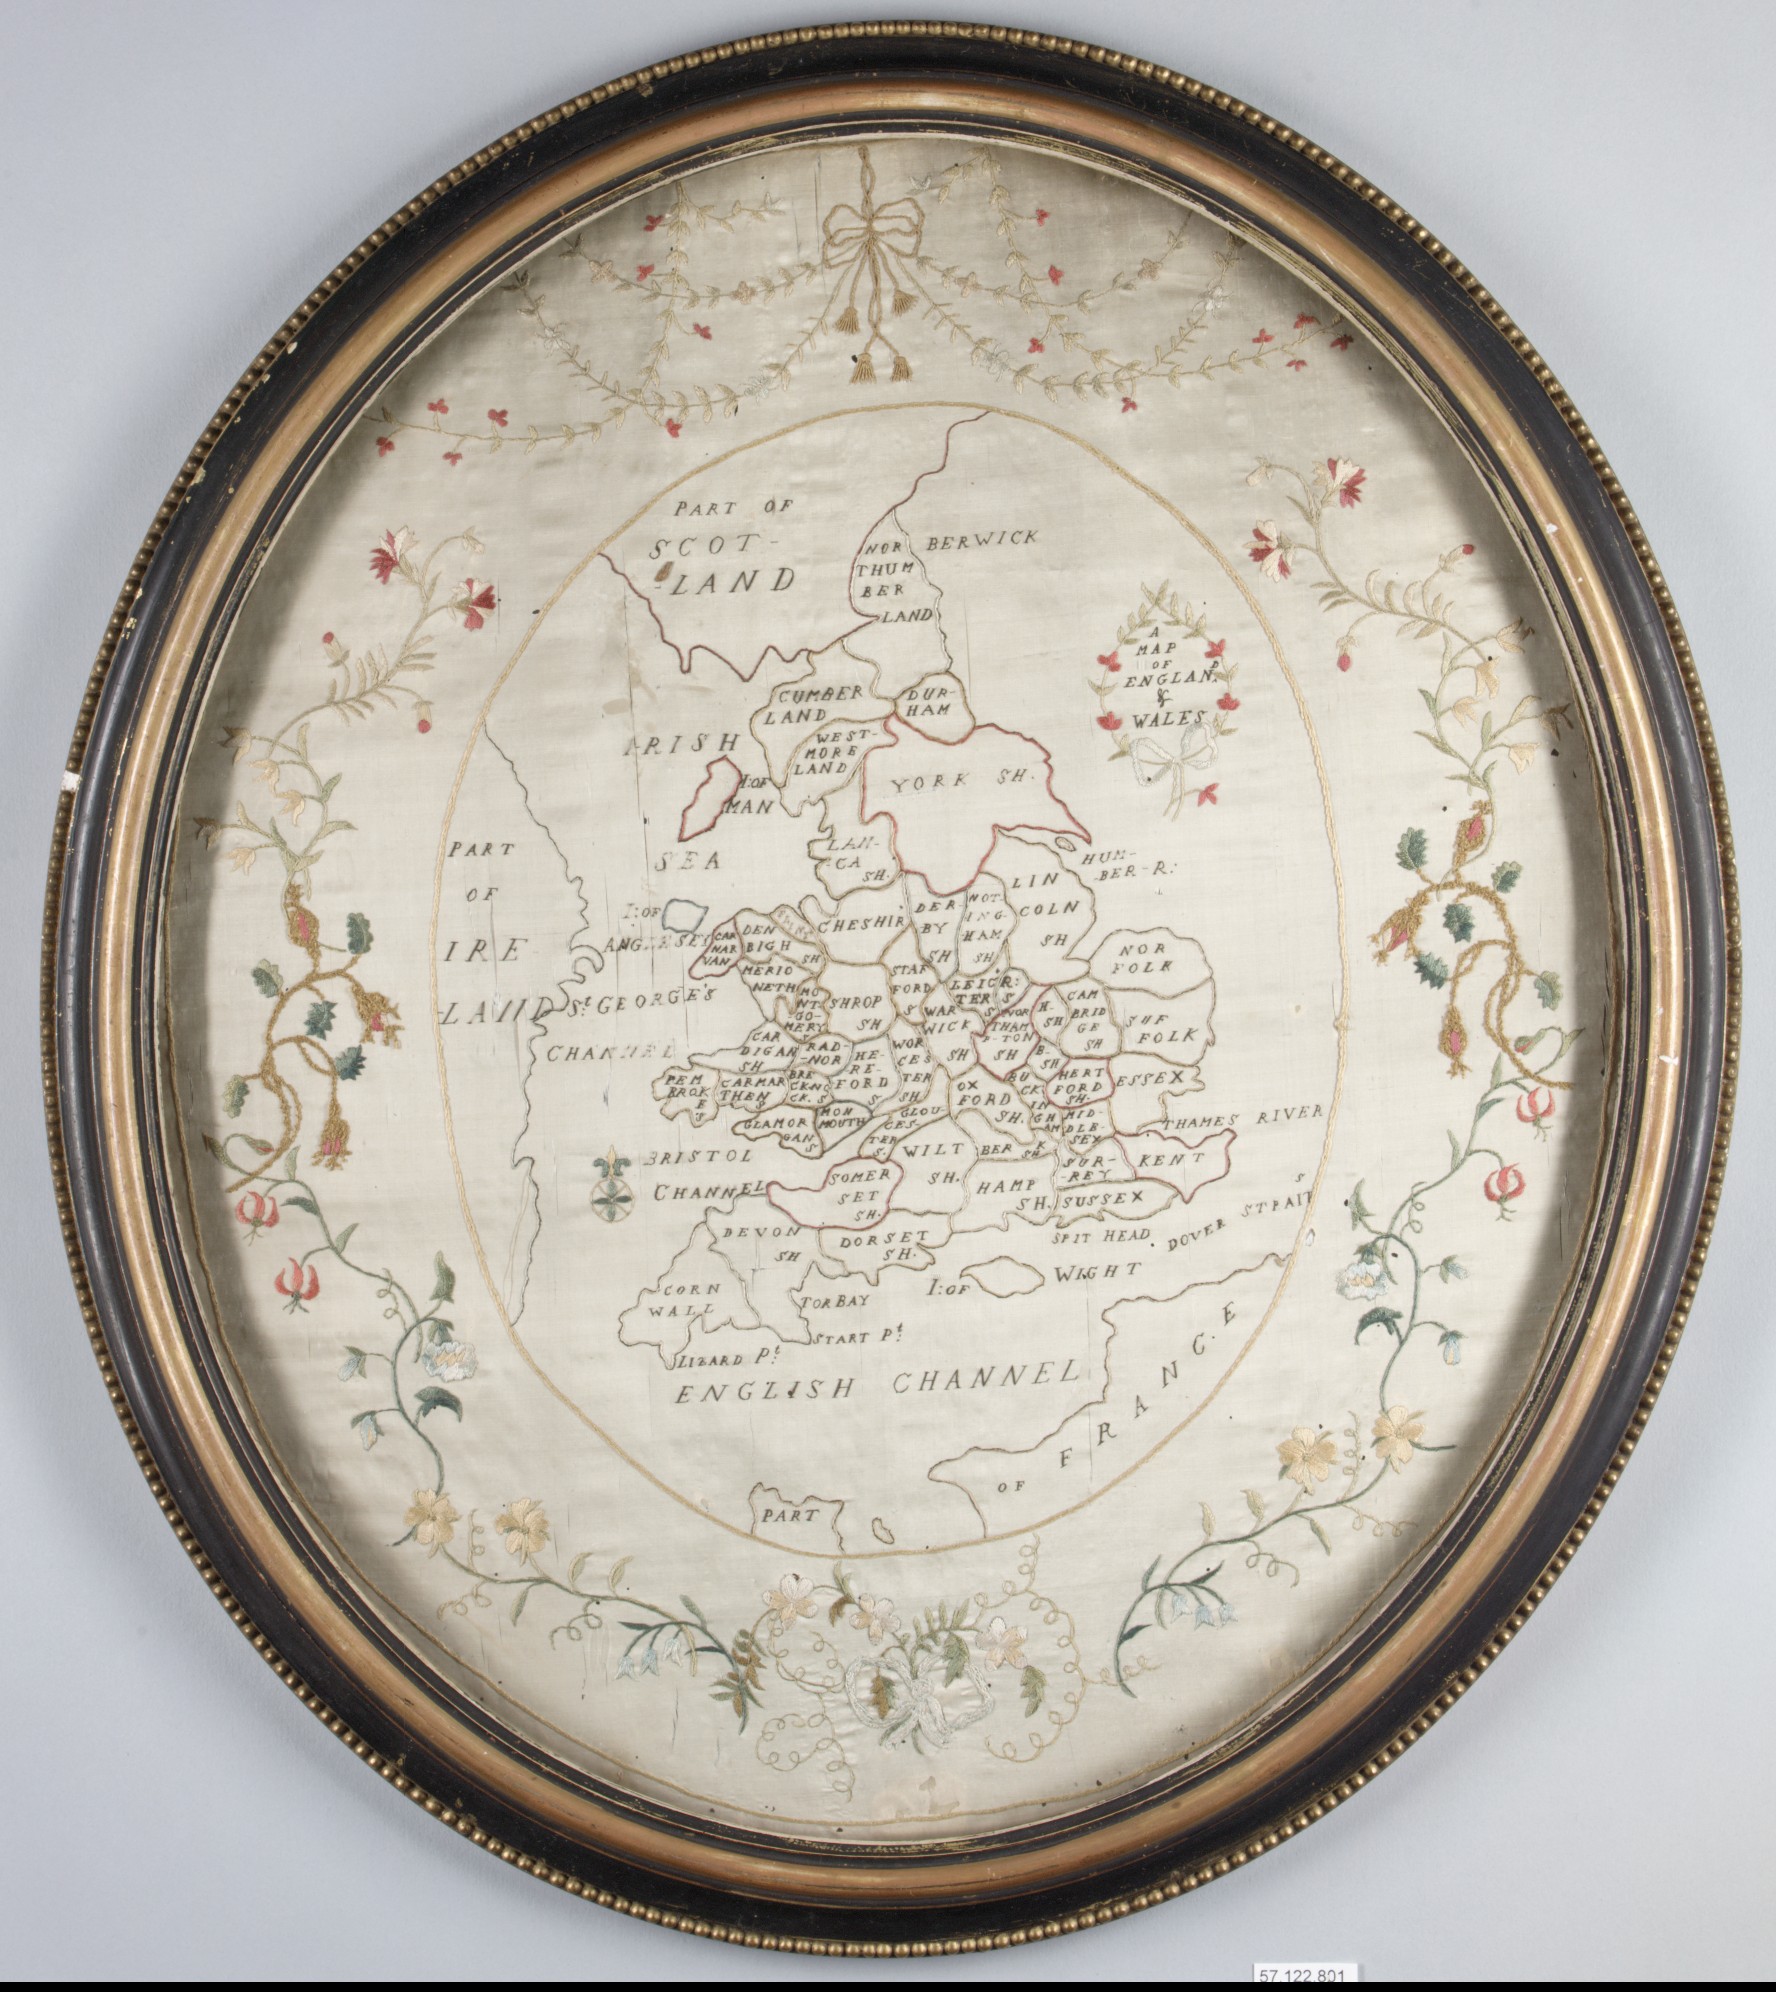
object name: sampler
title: Embroidered map sampler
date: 1767-1833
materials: silk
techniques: embroidery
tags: flowers,maps